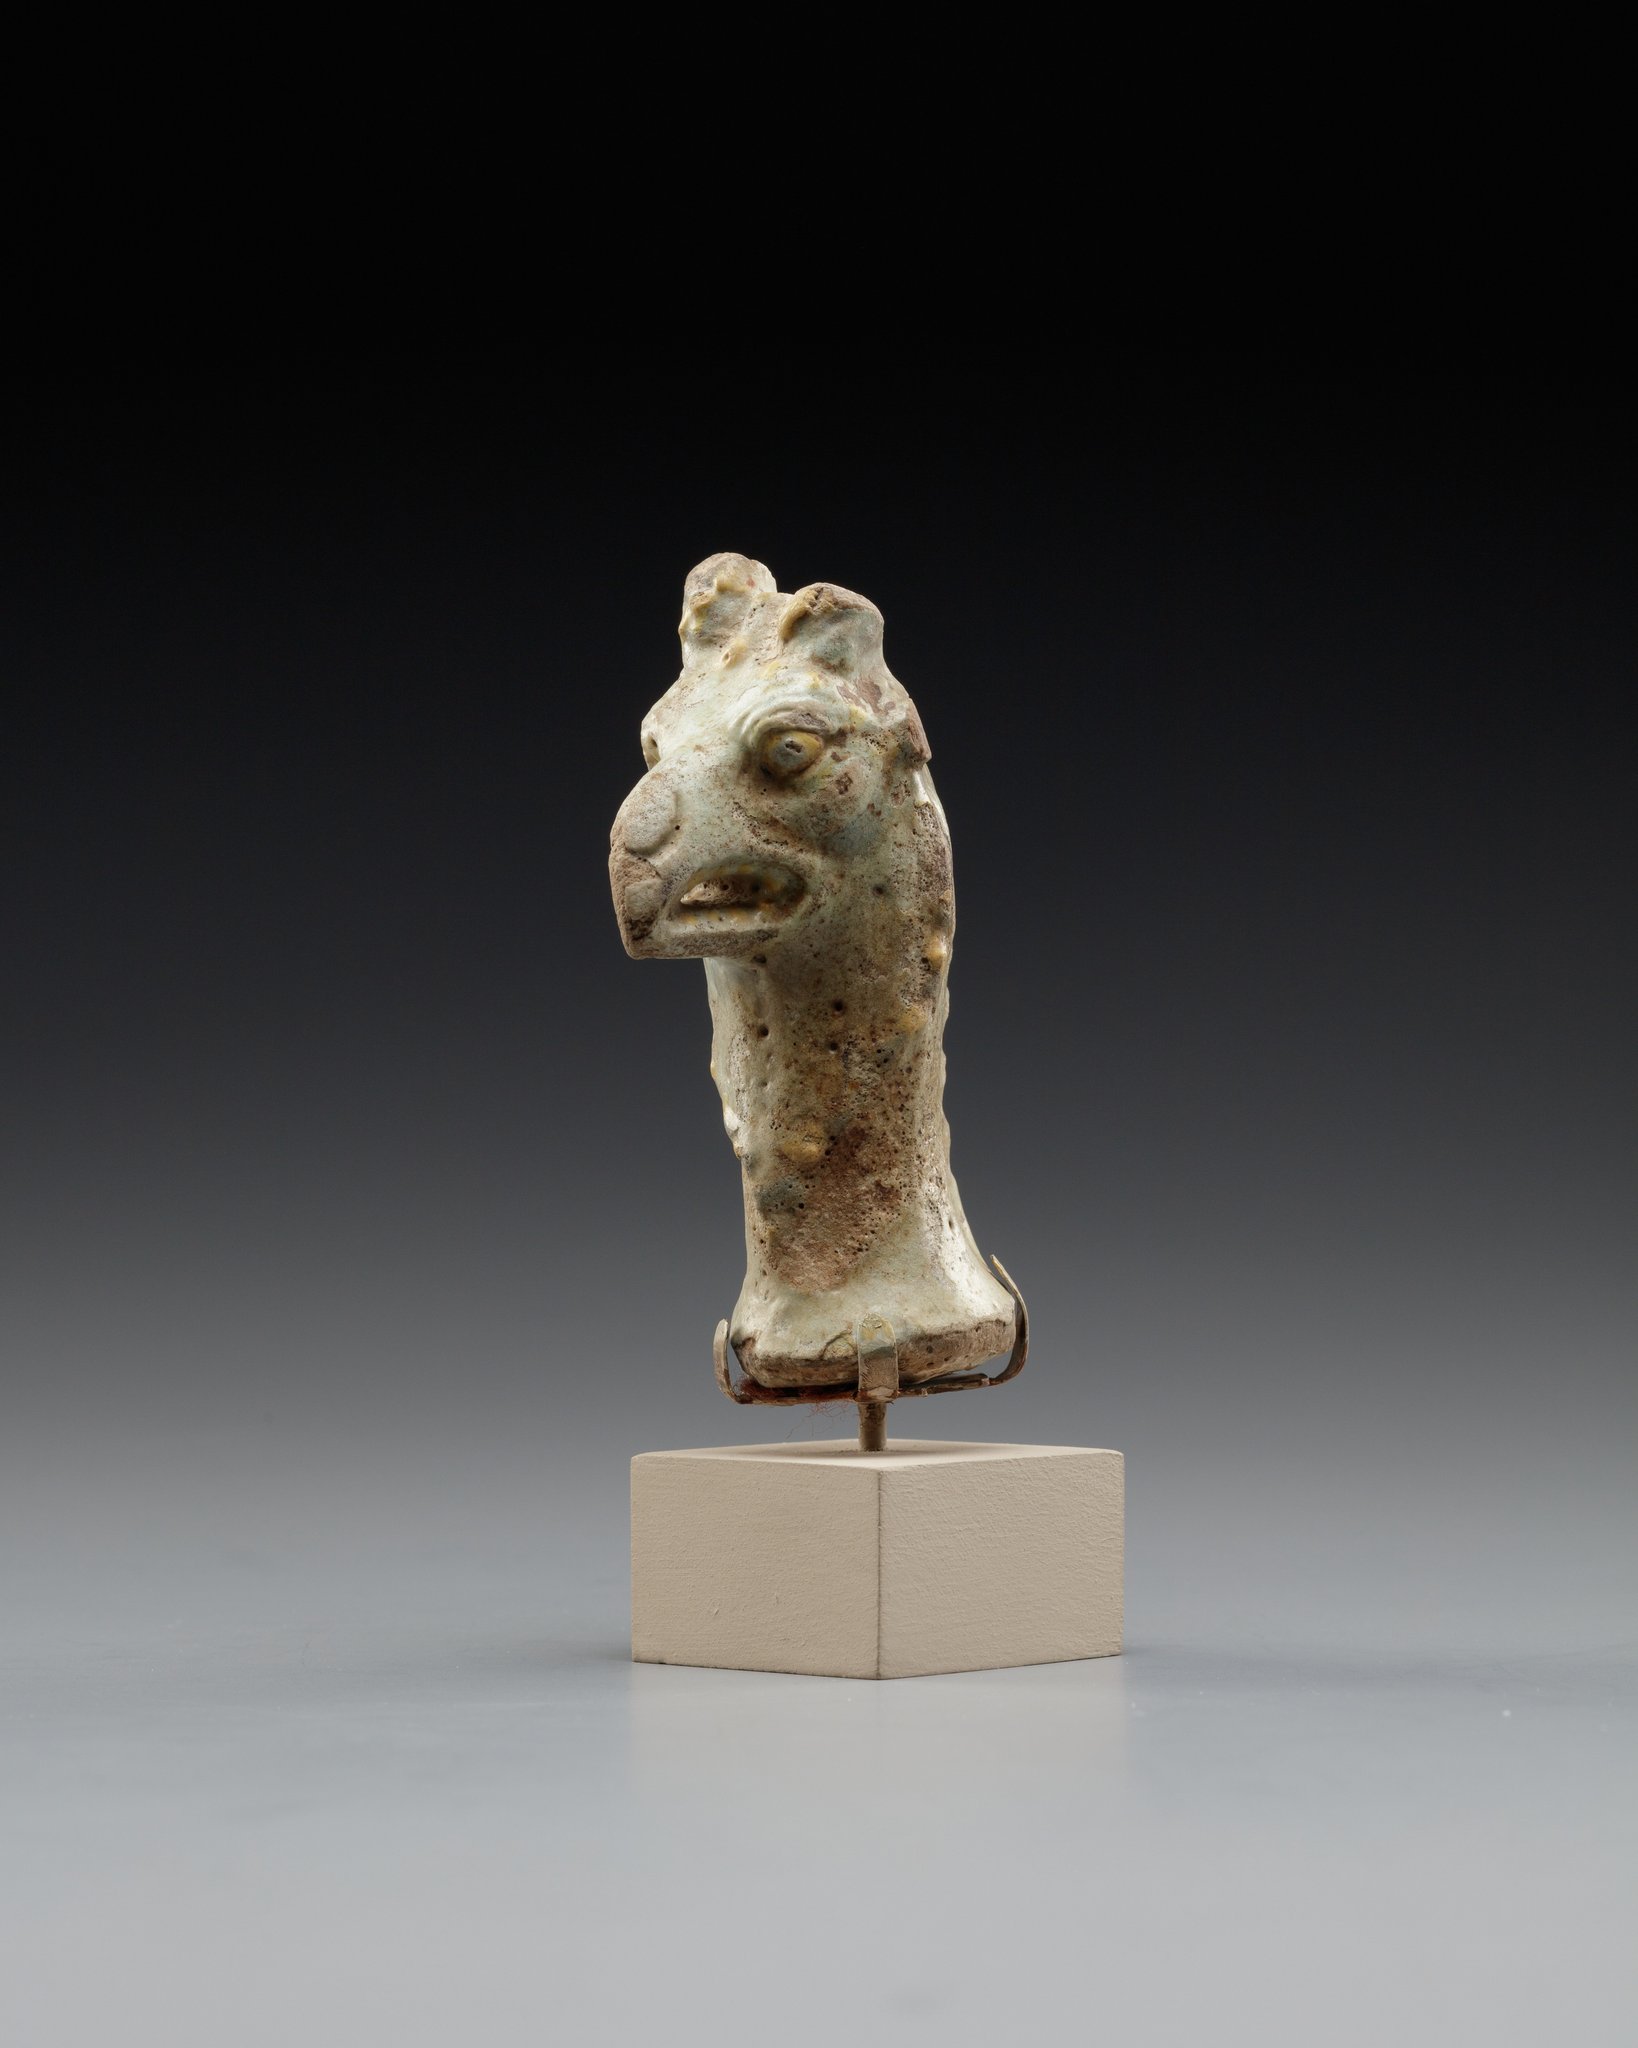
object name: figurine, griffin head, nemesis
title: Head of a figure of a griffin, perhaps representing Nemesis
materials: faience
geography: egypt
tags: griffins